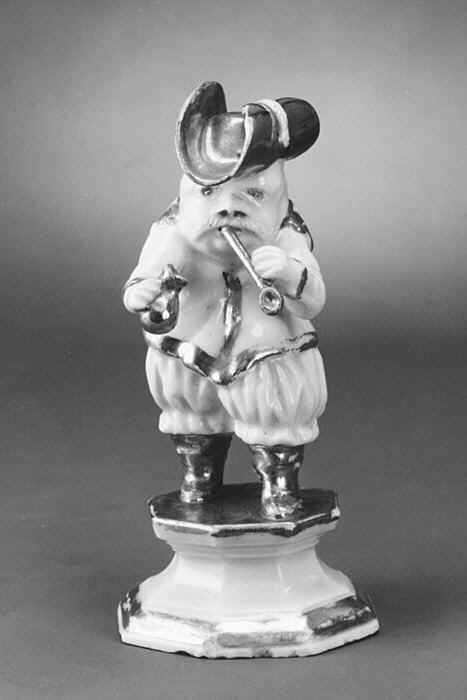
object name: figure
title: Callot dwarf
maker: meissen manufactory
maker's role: manufactory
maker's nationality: german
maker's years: 1710-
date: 1710-1719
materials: hard paste porcelain